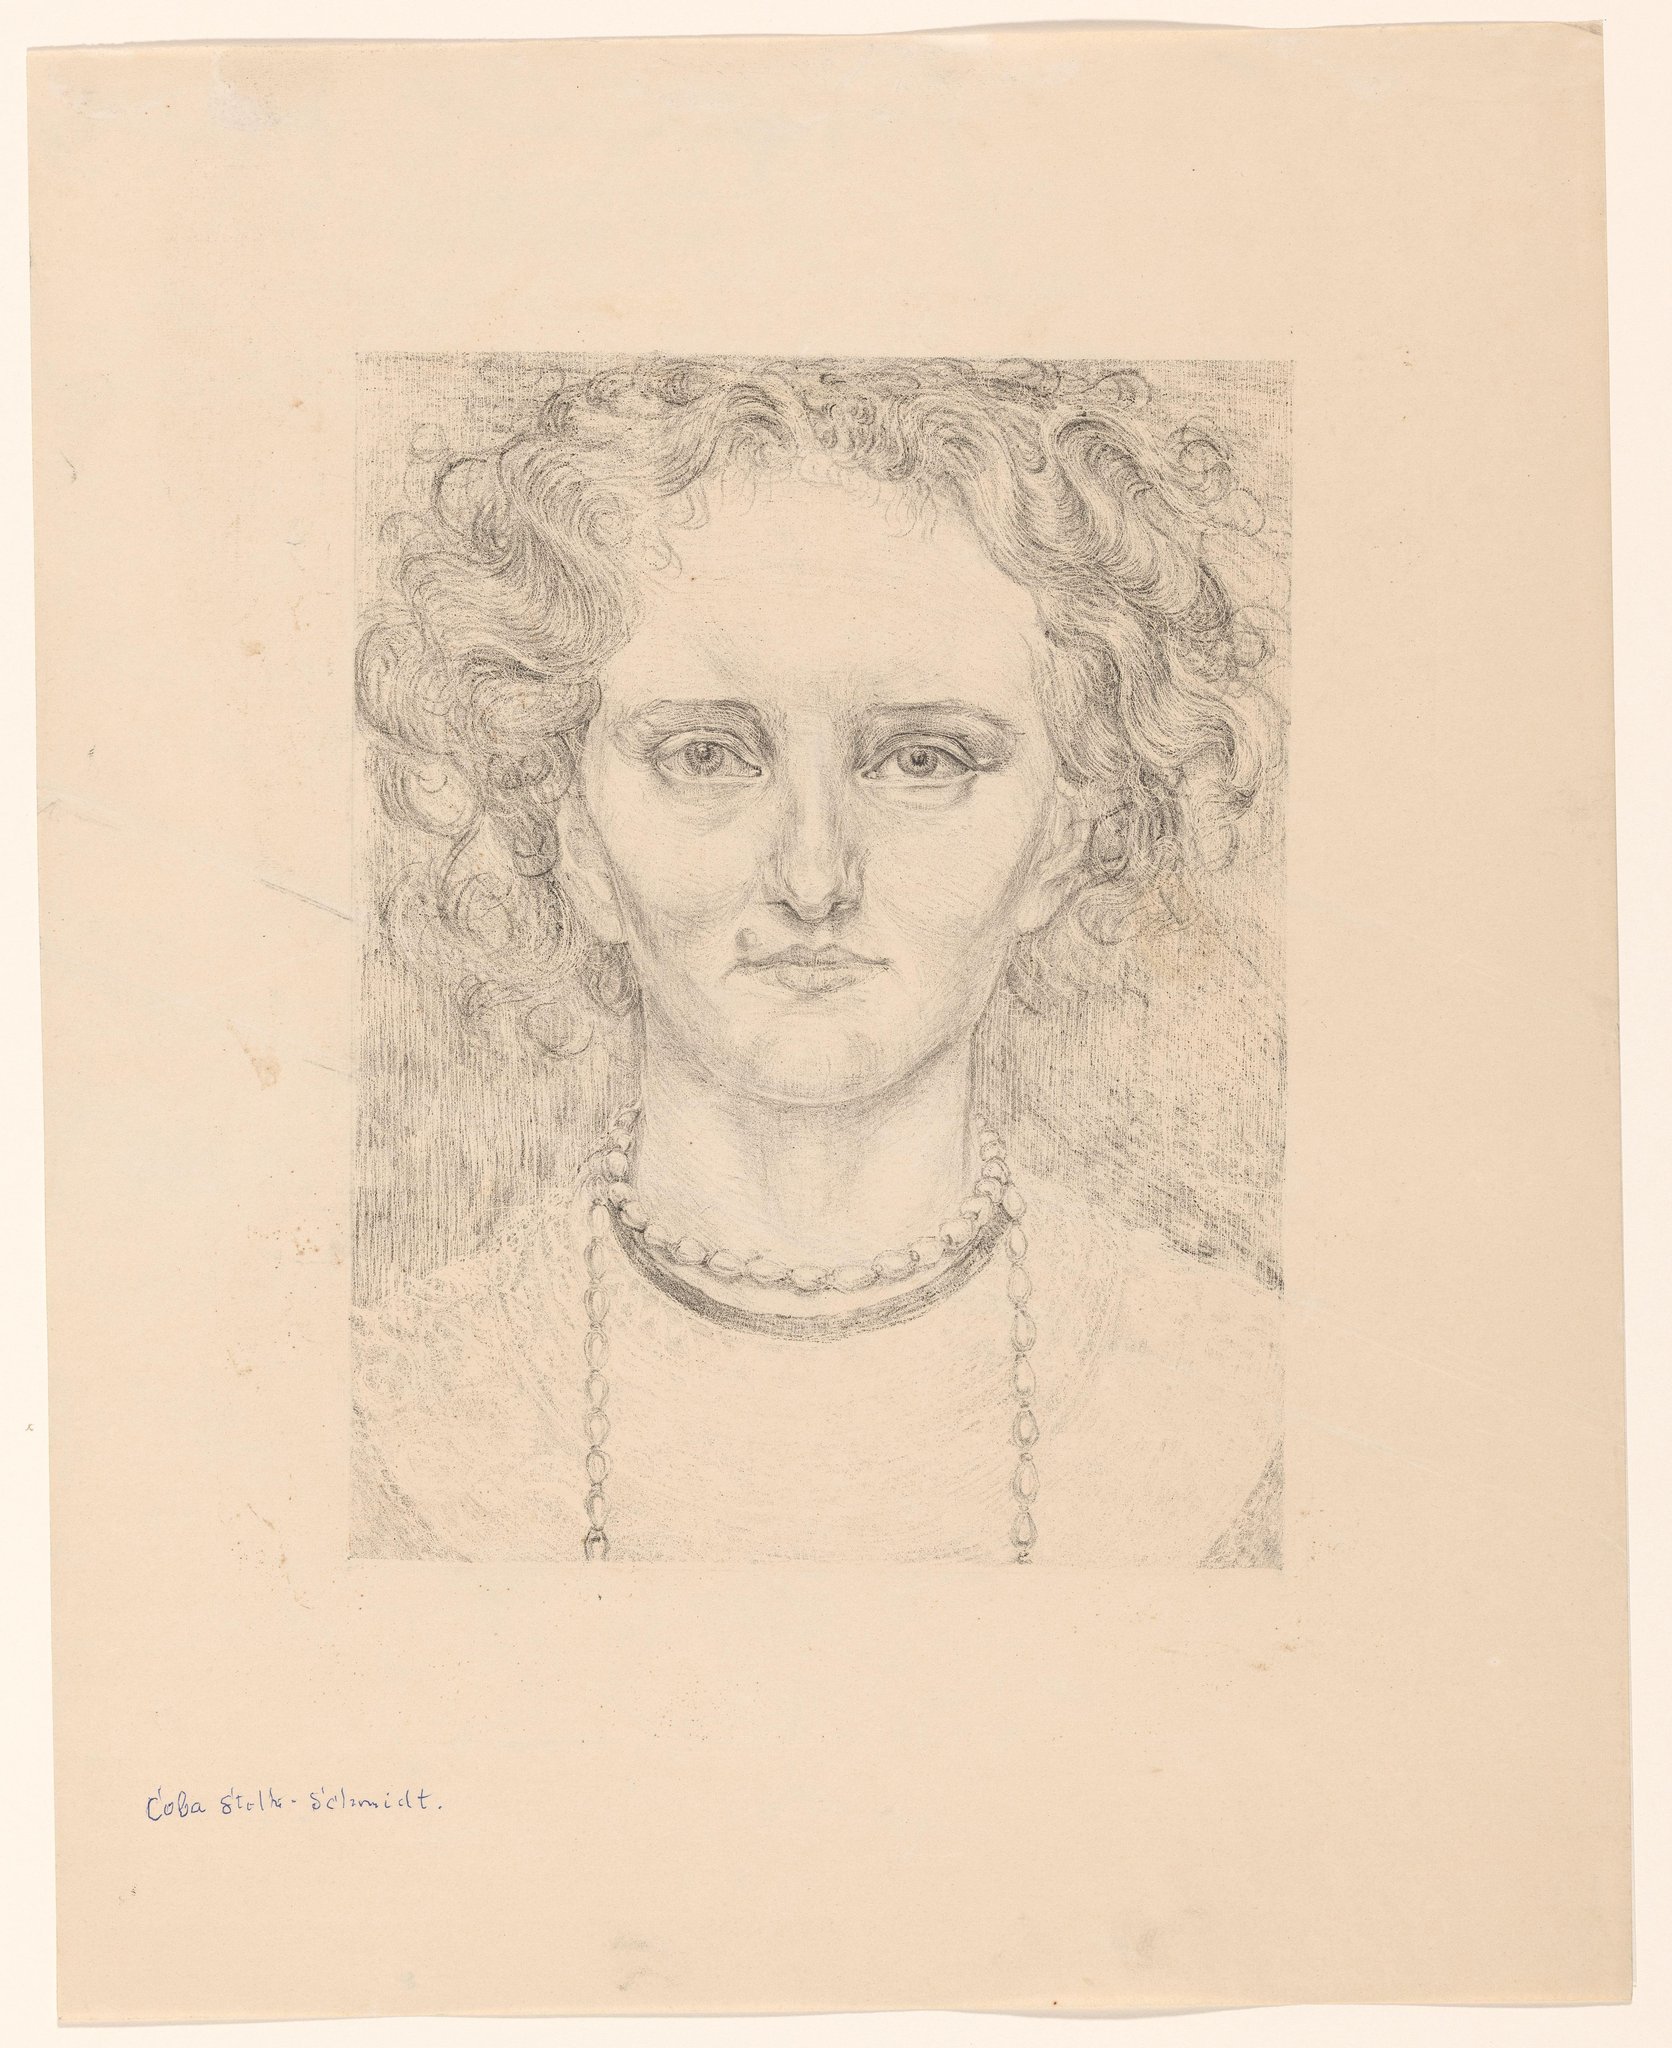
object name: print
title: Portret van Coba Stolk-Schmidt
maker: reijer stolk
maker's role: draughtsman, print maker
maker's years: 1896-1945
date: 1906-1945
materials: paper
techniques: lithograph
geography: netherlands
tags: historical persons - bb - woman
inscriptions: collector's mark: Lugt 2228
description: De vrouw heeft krullend haar en draagt een ketting om haar hals.